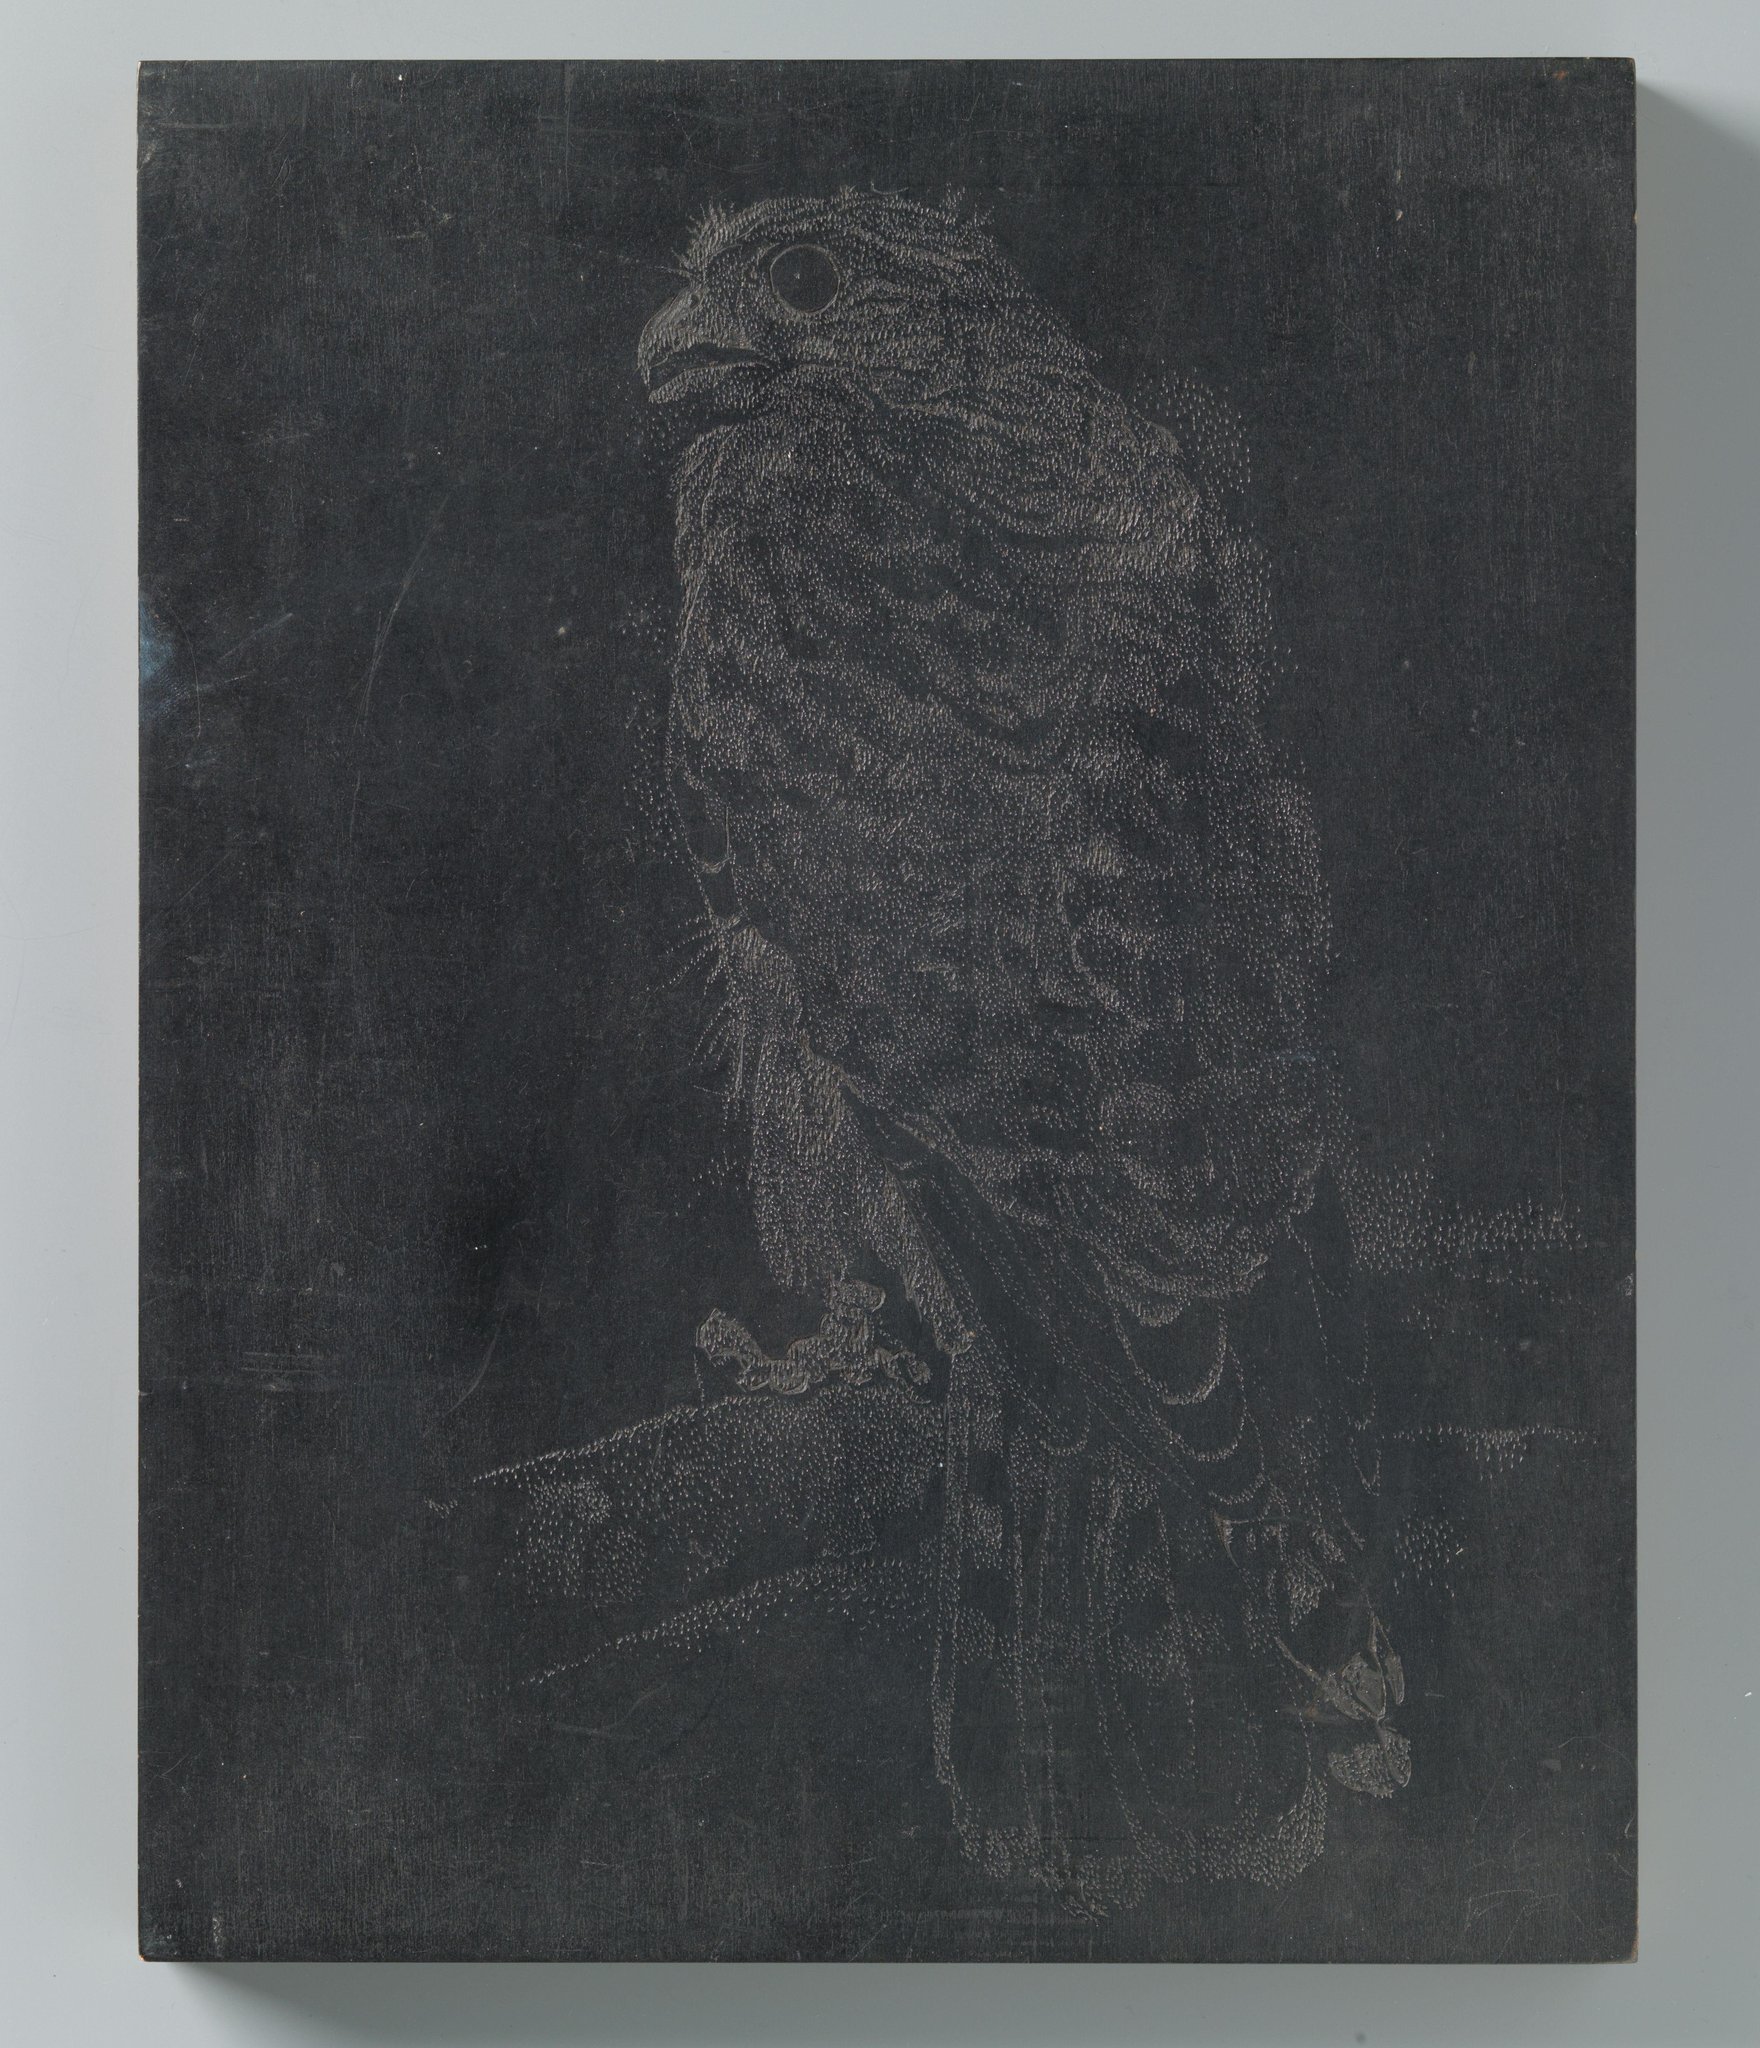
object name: wood block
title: Roofvogel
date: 1916-1947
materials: wood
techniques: engraving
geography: netherlands